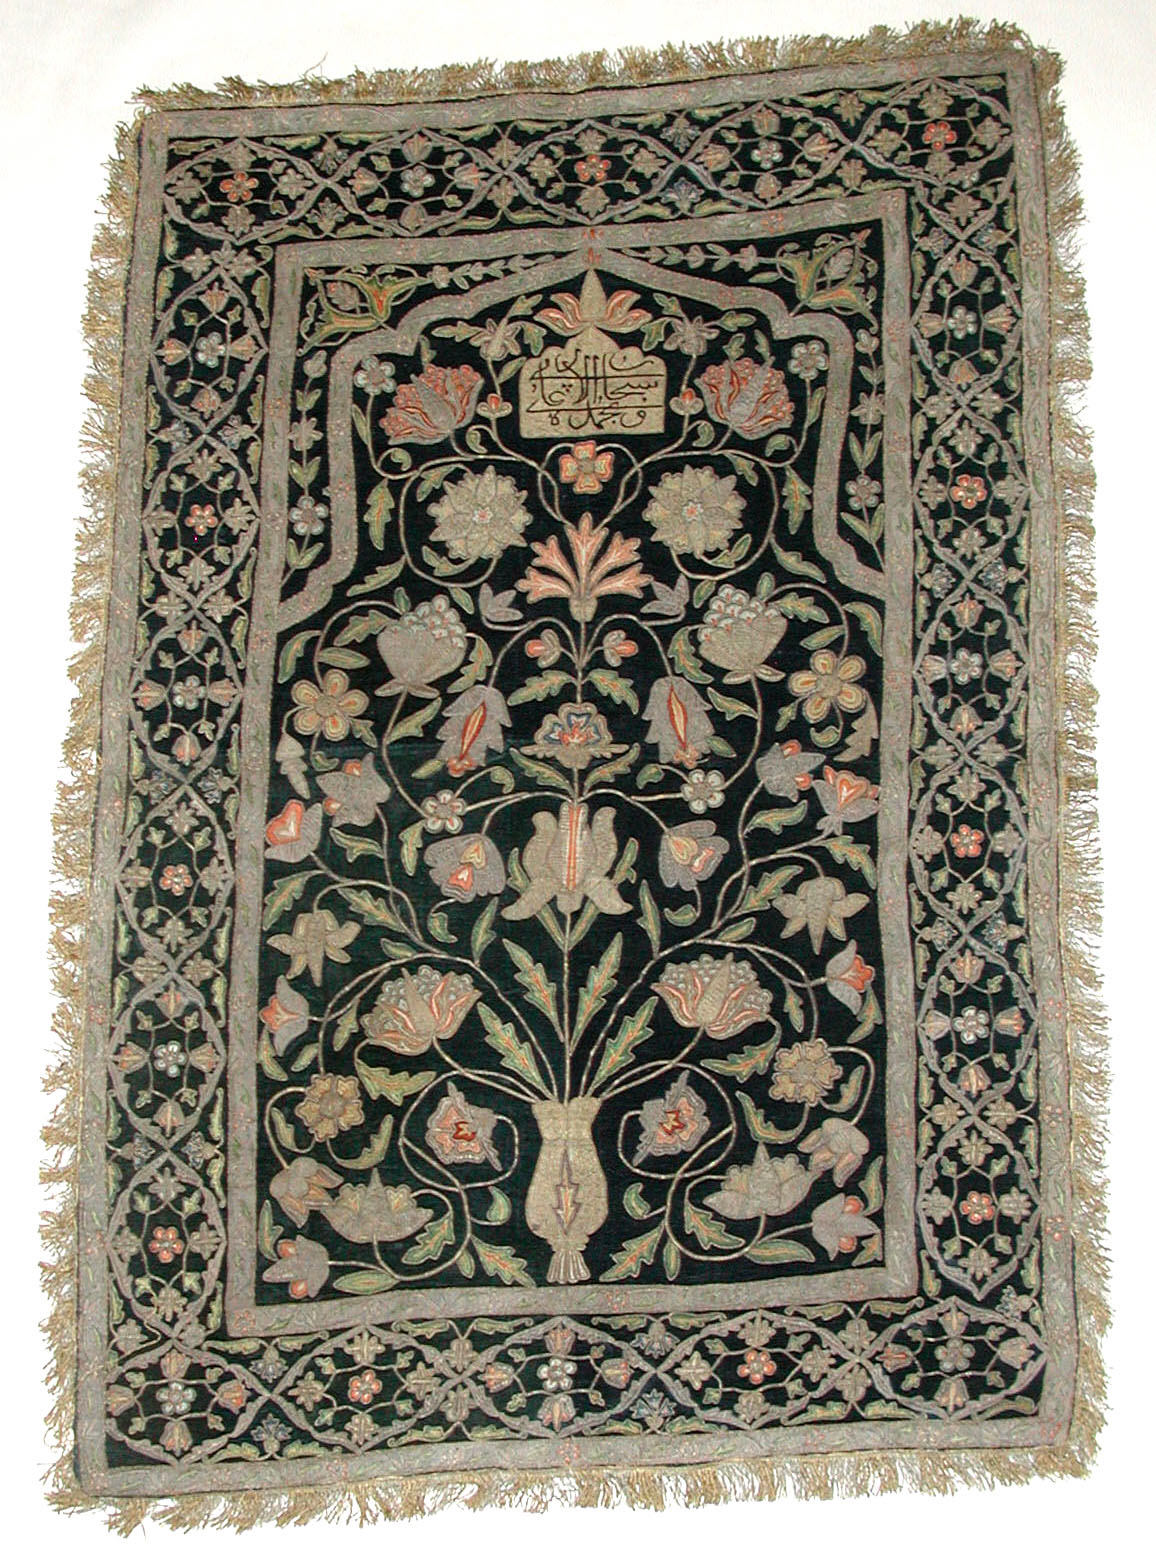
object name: hanging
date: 1701-1800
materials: metal thread, silk, velvet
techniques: embroidery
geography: iran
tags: flowers